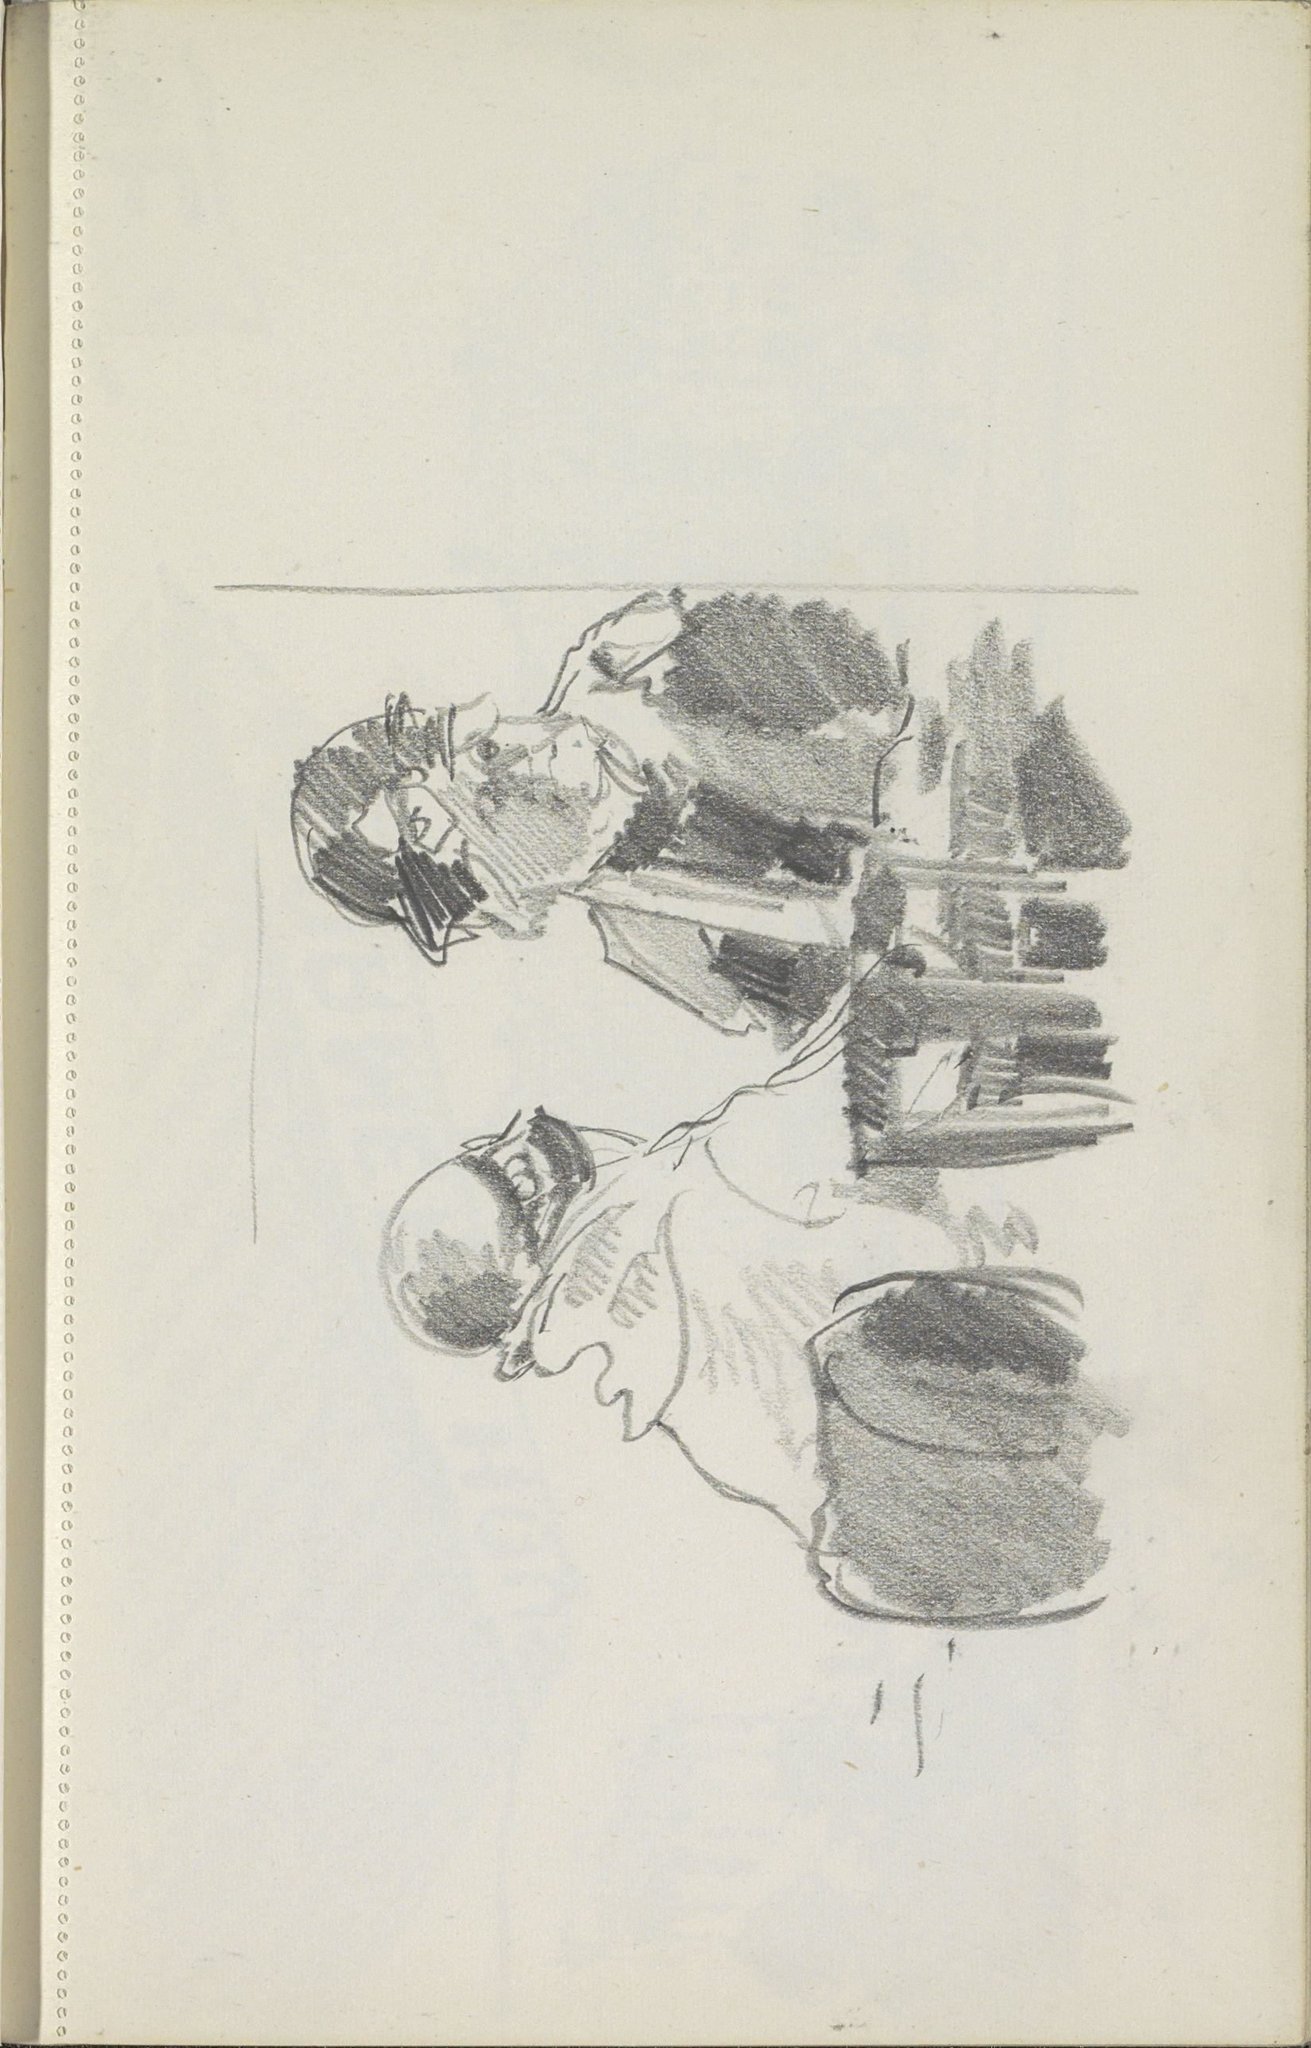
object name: sketchbook leaf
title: Twee vrouwen aan een tafel op een terras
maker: cornelis vreedenburgh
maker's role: draughtsman, print maker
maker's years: 1880-1946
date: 1890-1946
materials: paper, pencil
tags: sitting figure - aa - female human figure, pavement, terrace in front of inn or restaurant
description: De vrouwen dragen elk een hoed. Blad 37 recto uit een schetsboek met 50 bladen.